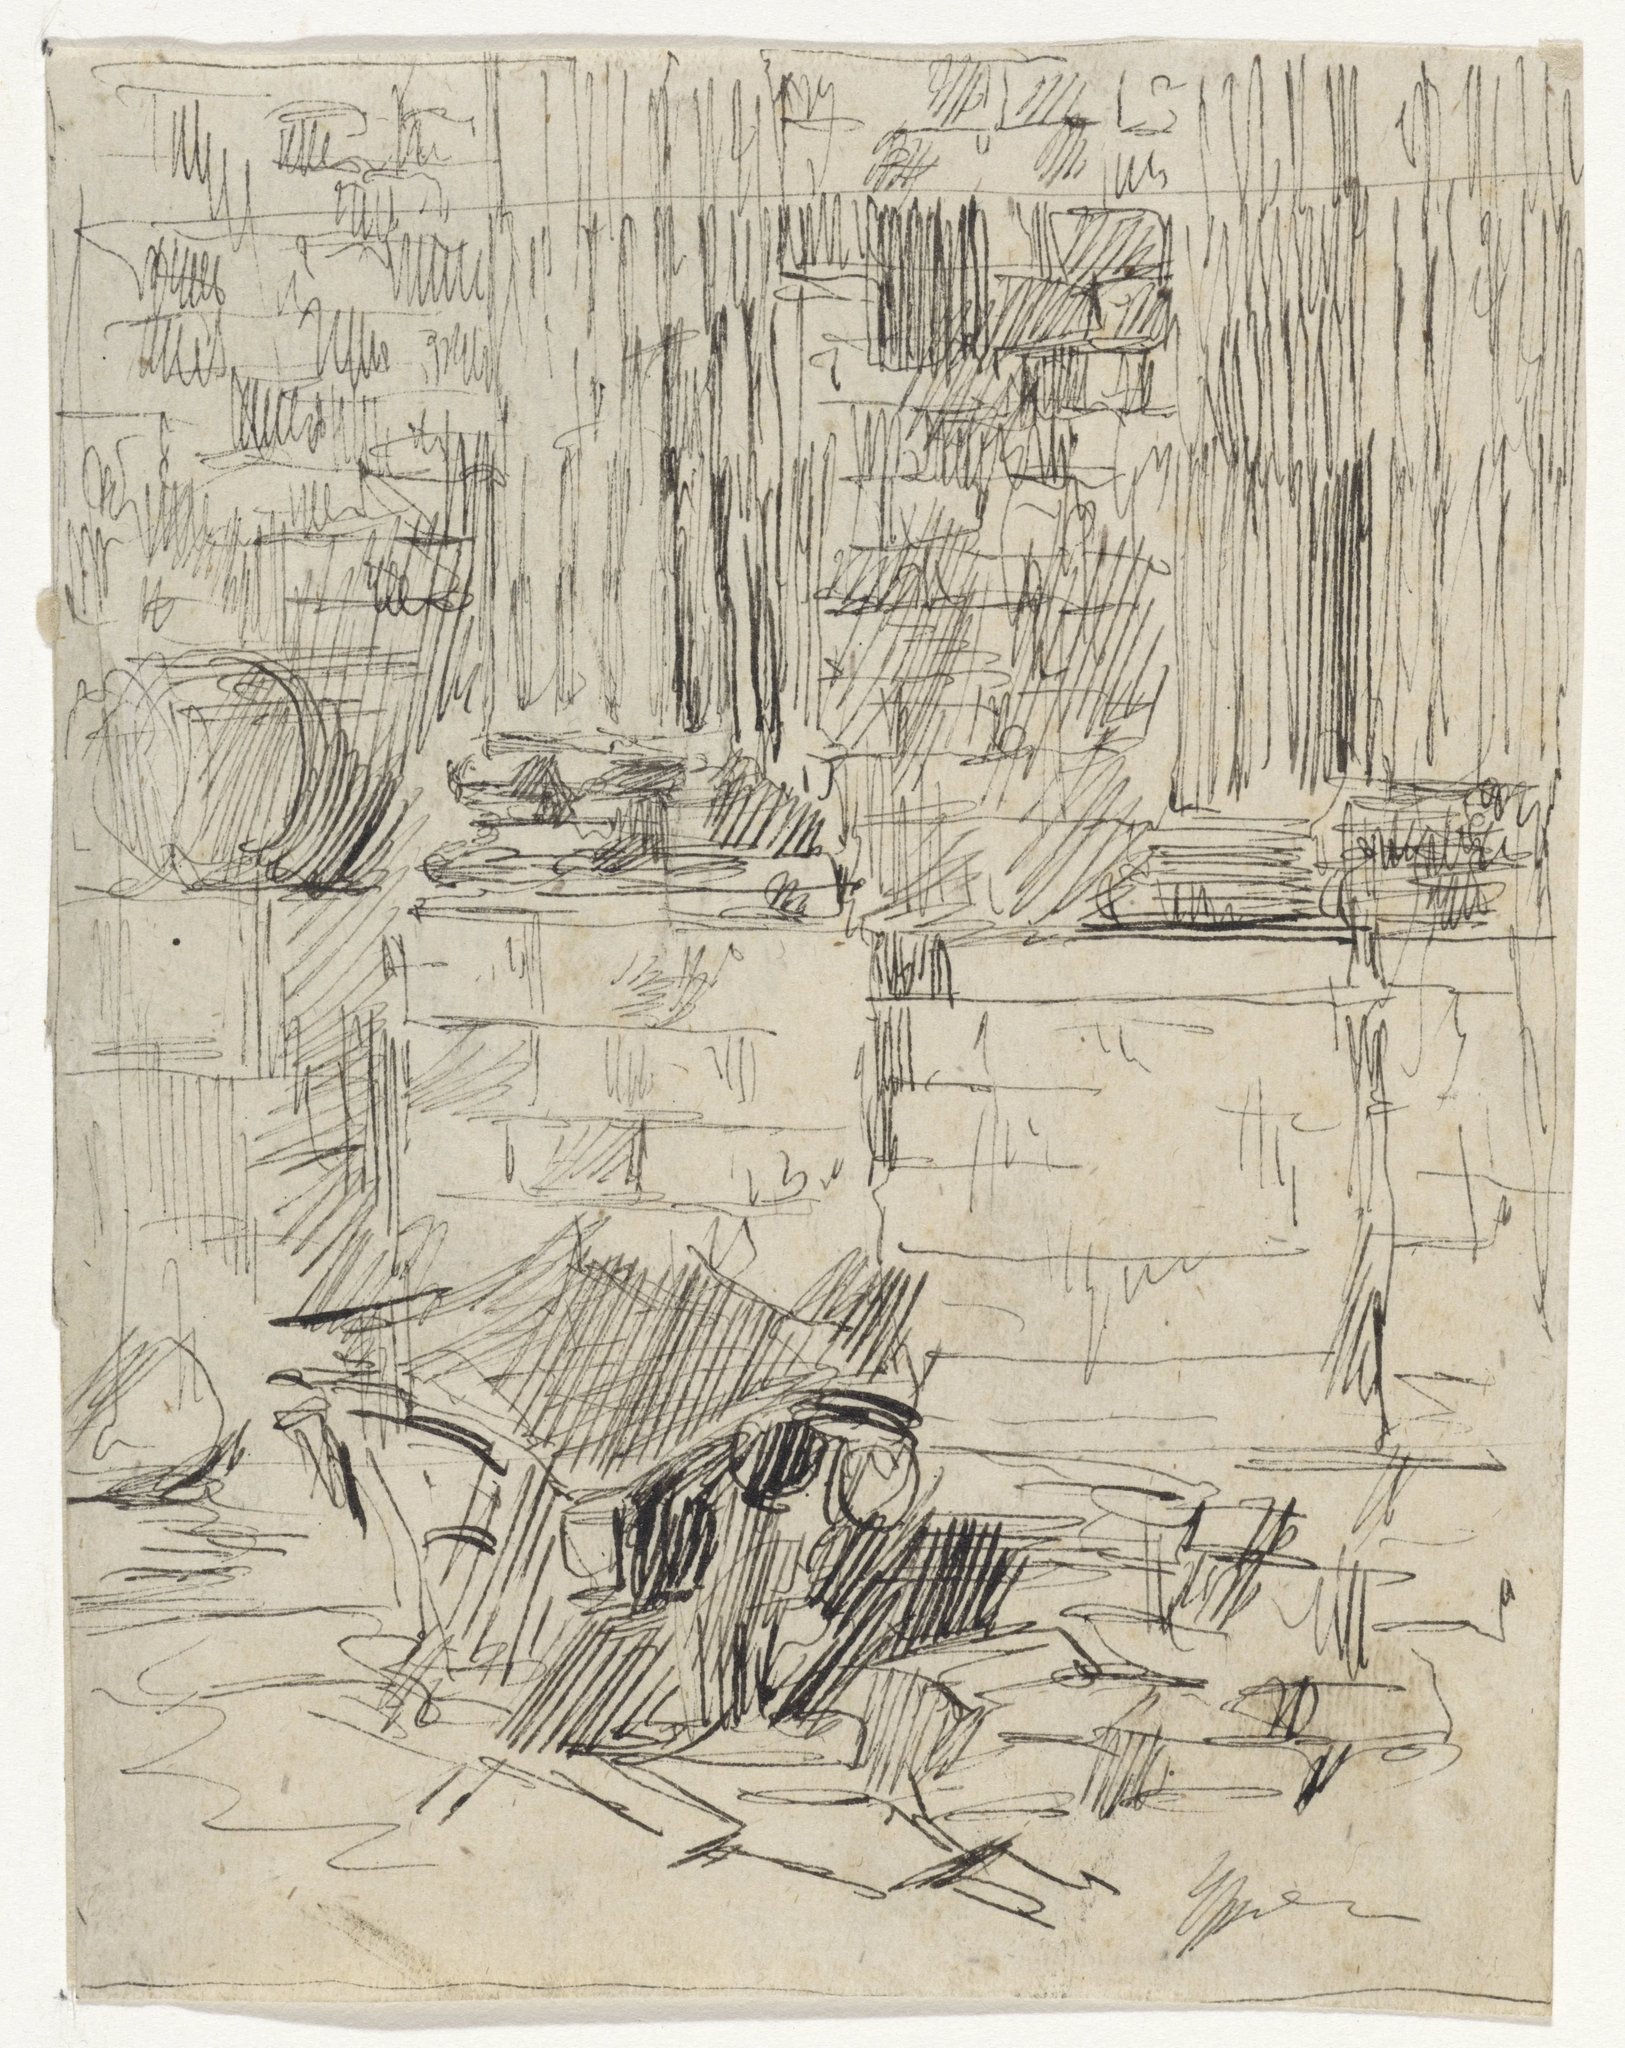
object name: drawing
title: Klassieke architectuur, met op de grond een Korintisch kapiteel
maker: thomas cool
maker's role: draughtsman, painter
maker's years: 1851-1904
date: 1861-1904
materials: ink, paper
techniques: pen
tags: landscape with ruins, rome